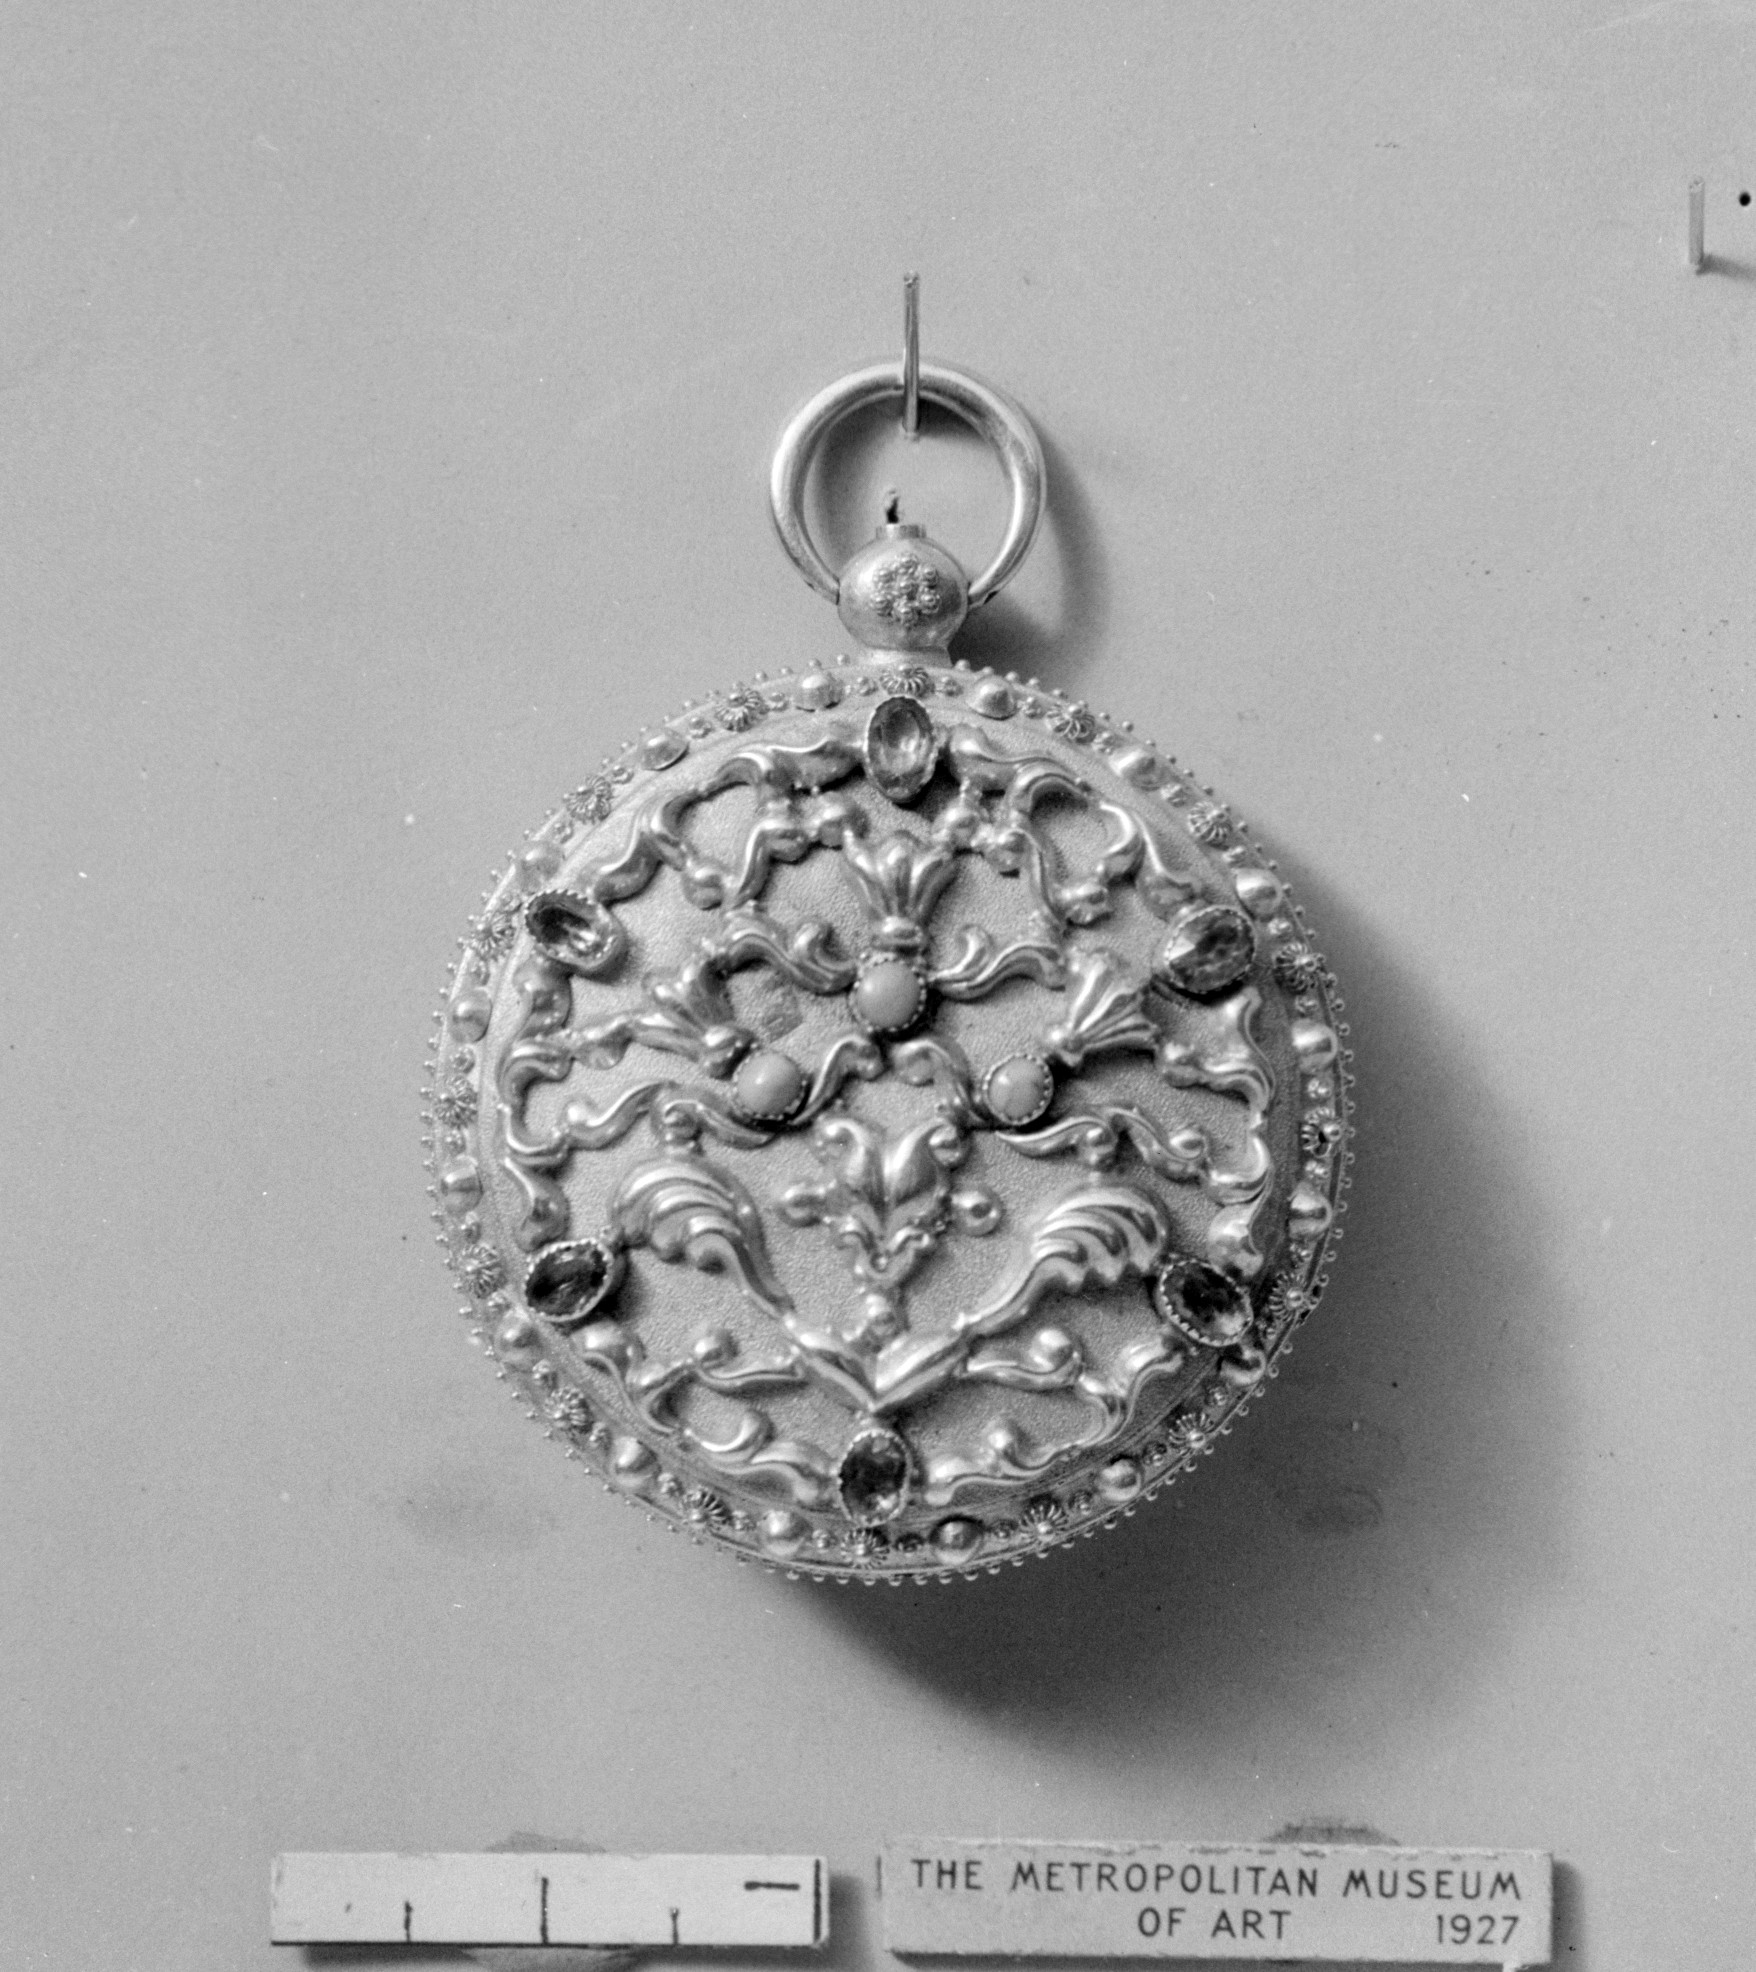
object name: watch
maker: firm of bordier frères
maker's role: maker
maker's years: 1820-1830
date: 1815-1830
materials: gold, gemstone